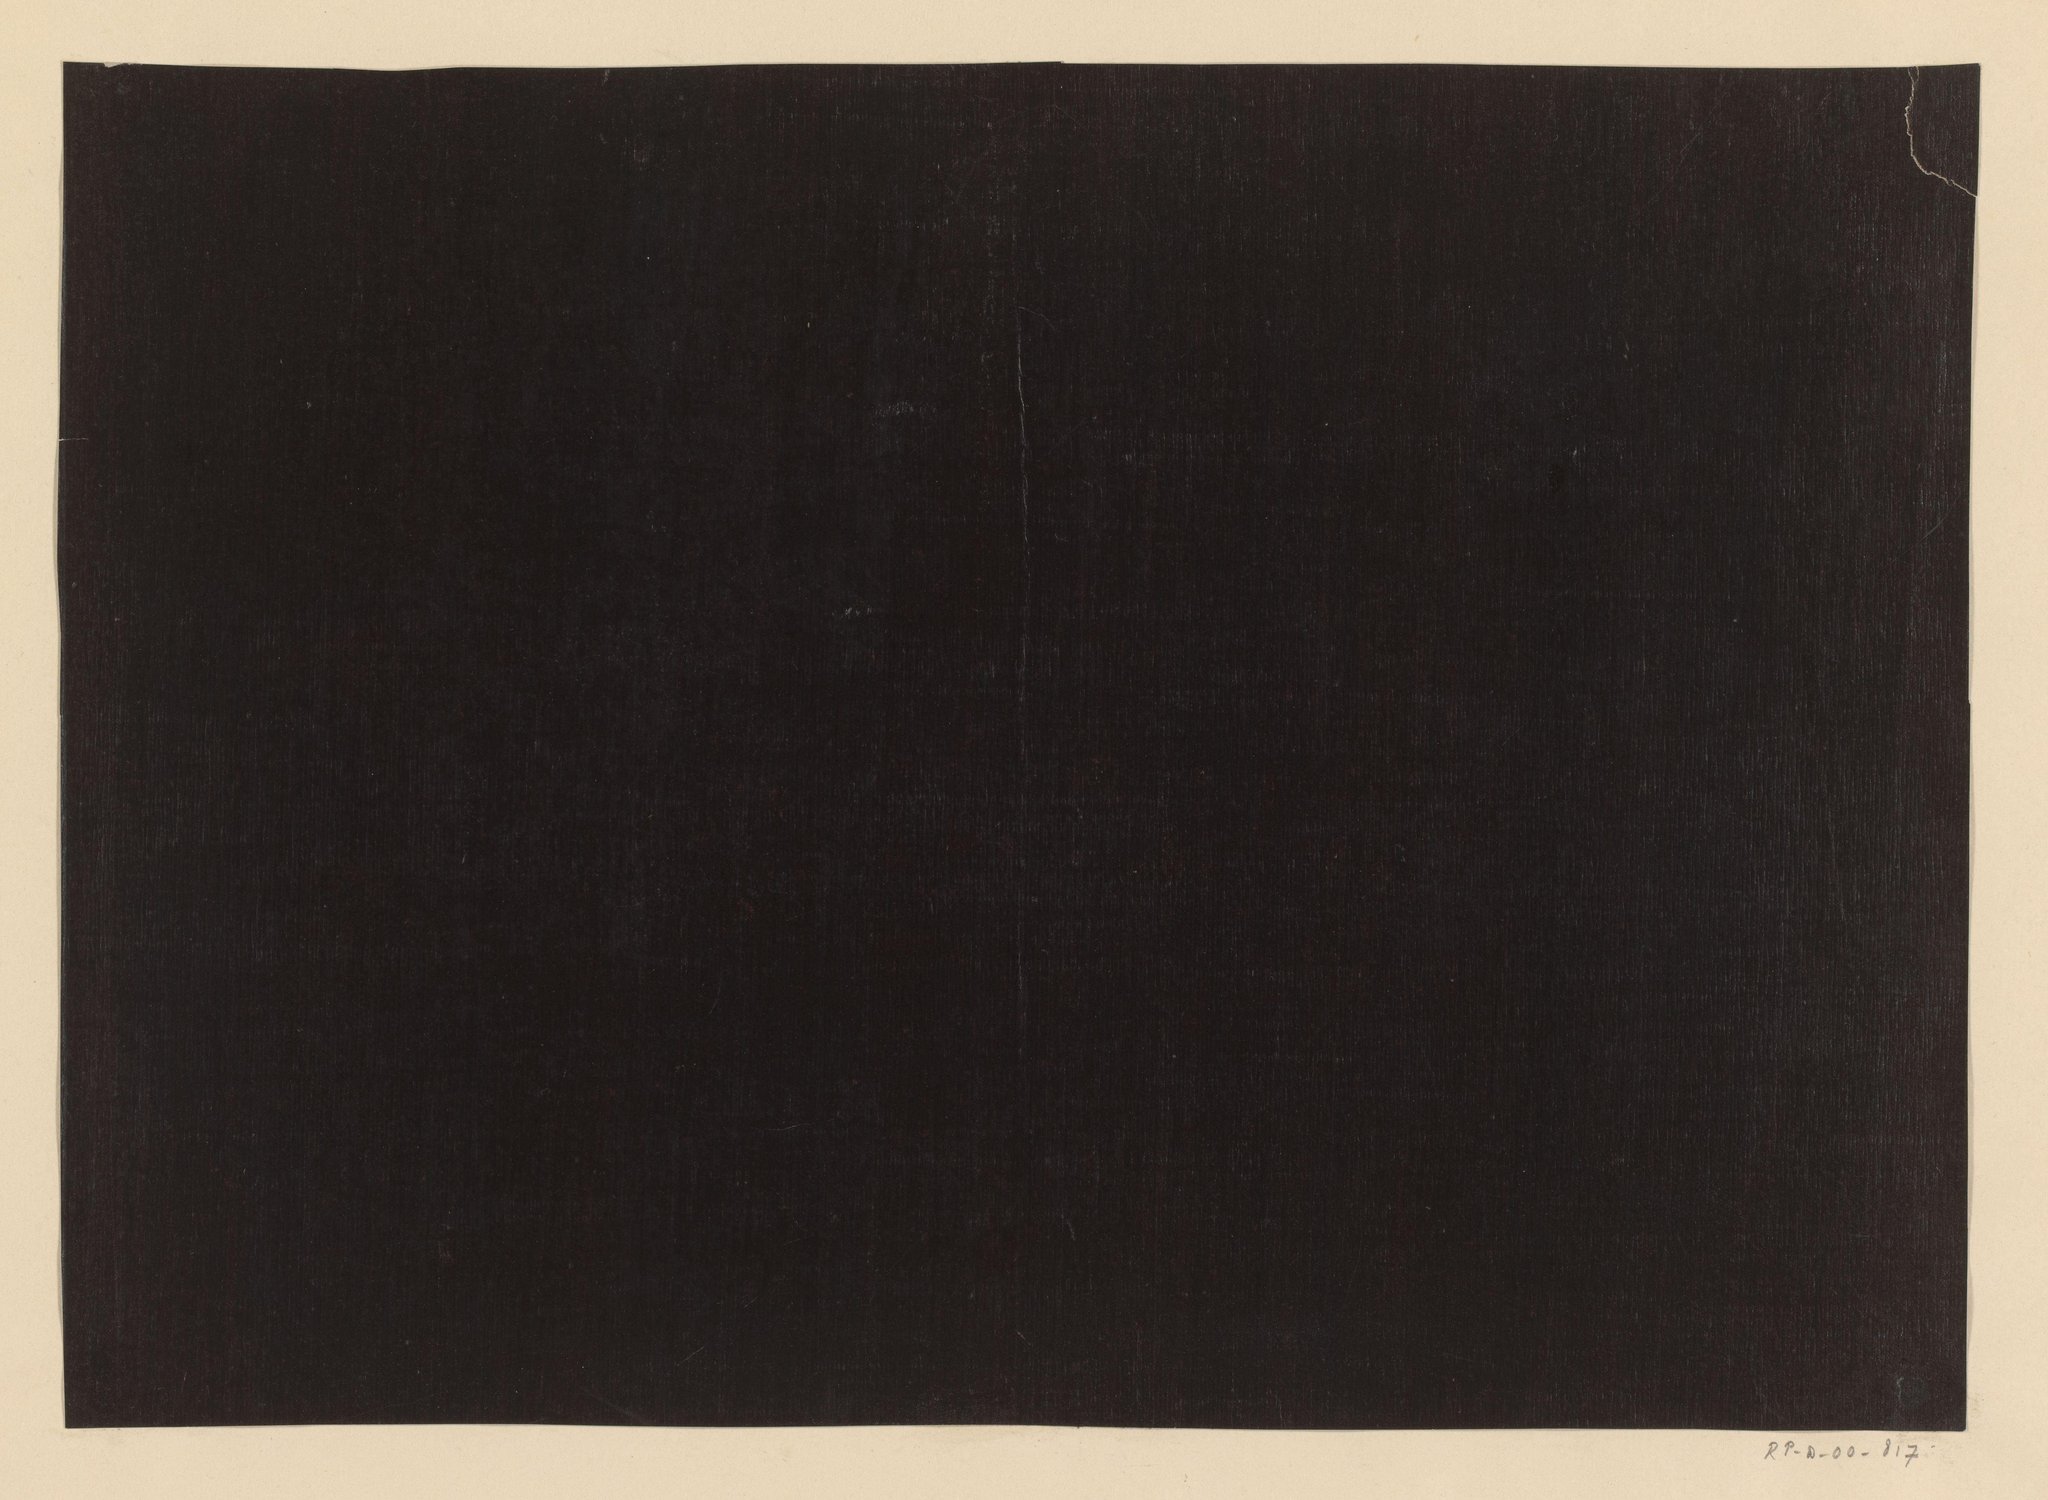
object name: decorated paper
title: Effen zwart papier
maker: Anonymous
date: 1800-1900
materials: lacquer, paint, paper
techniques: hand coloring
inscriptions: collector's mark: Lugt 2760